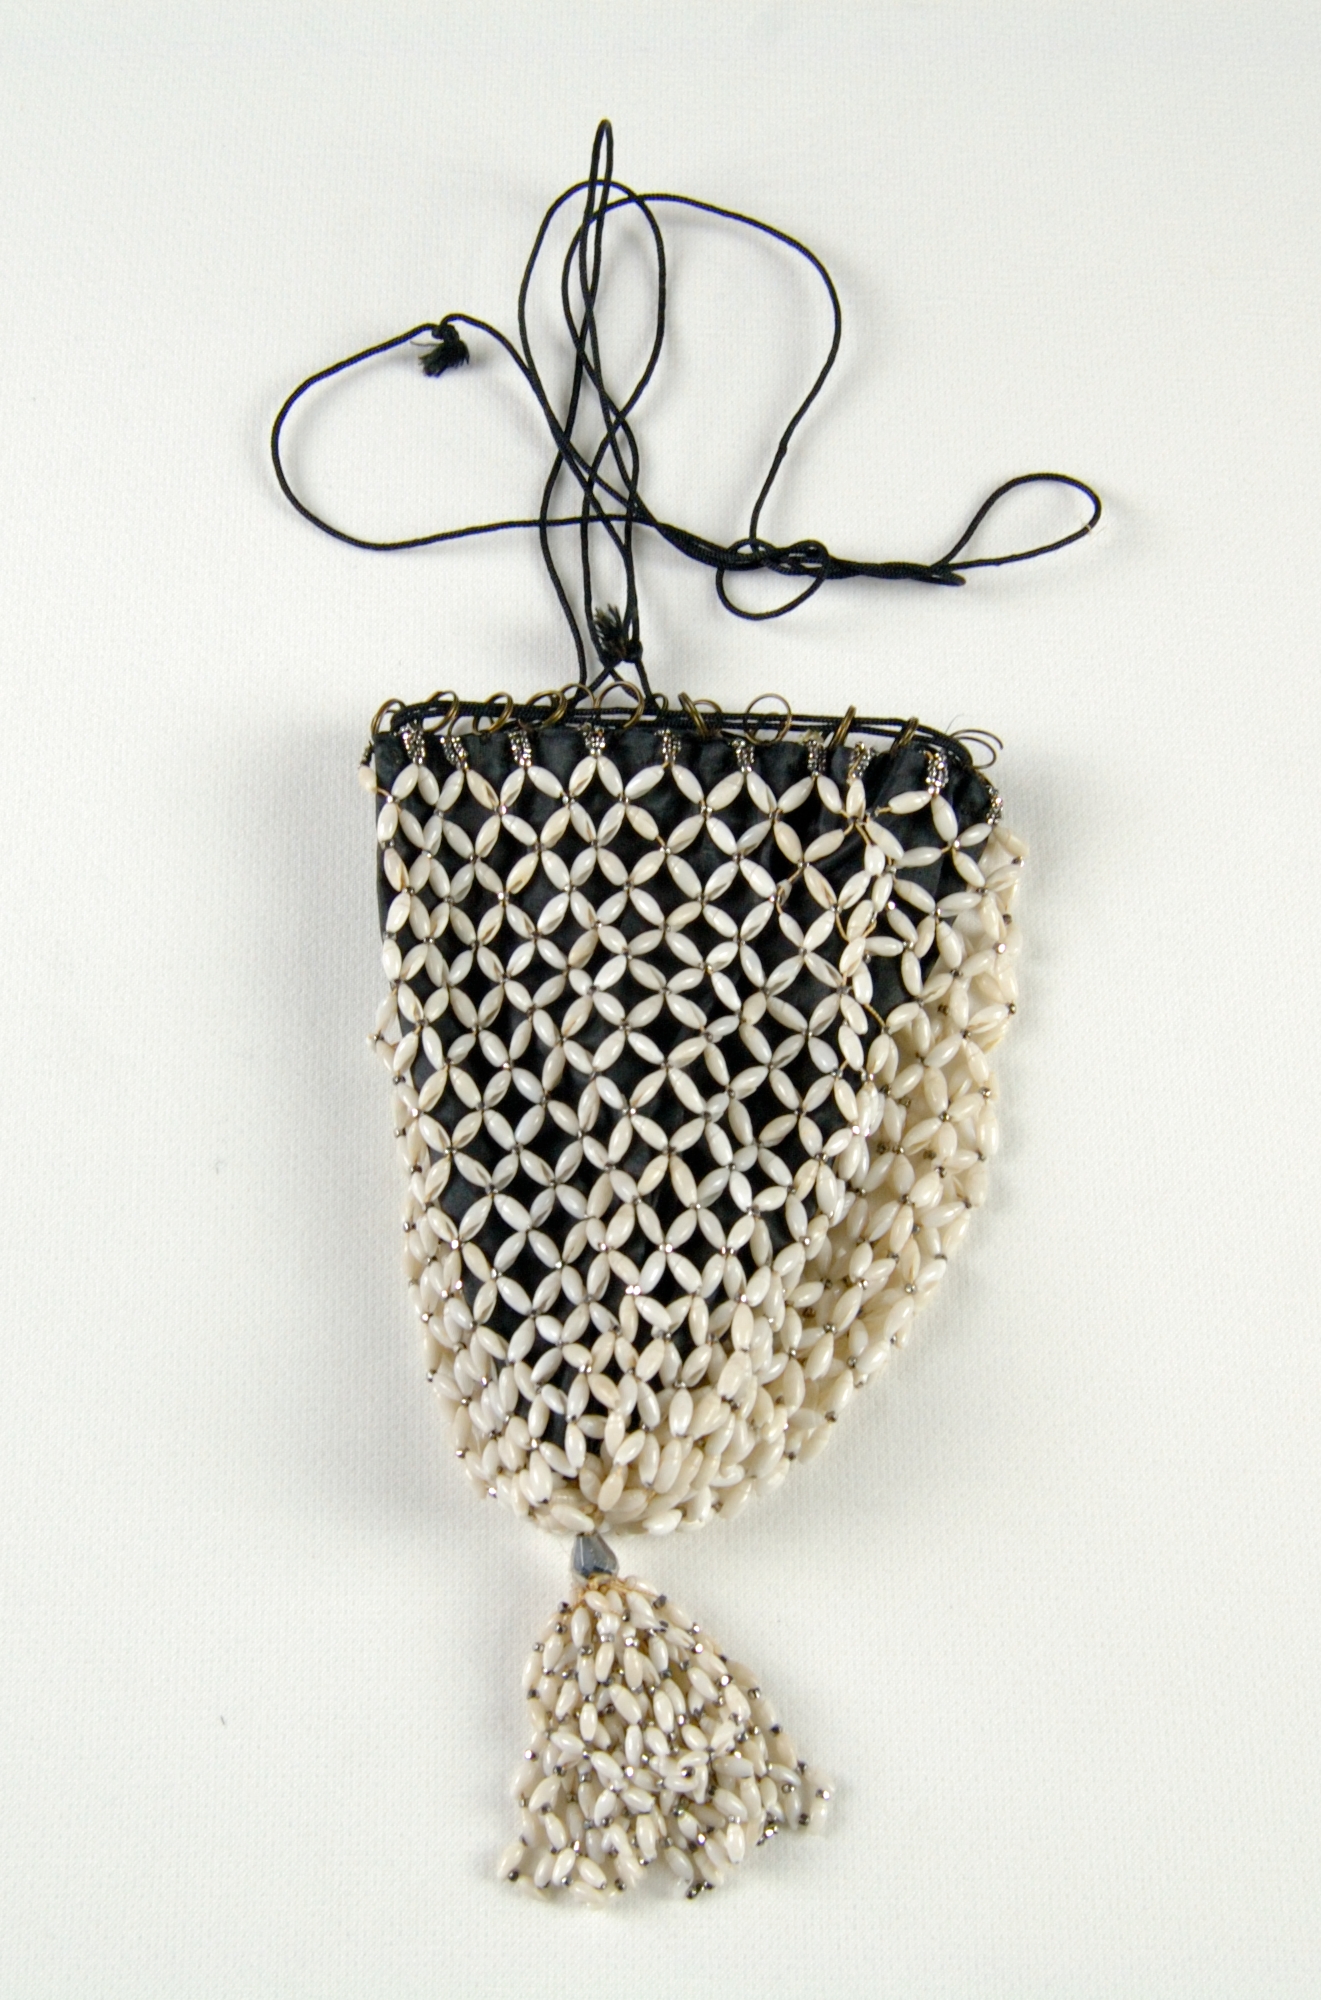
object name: pouch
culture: american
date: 1820-1830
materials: metal, shell, silk